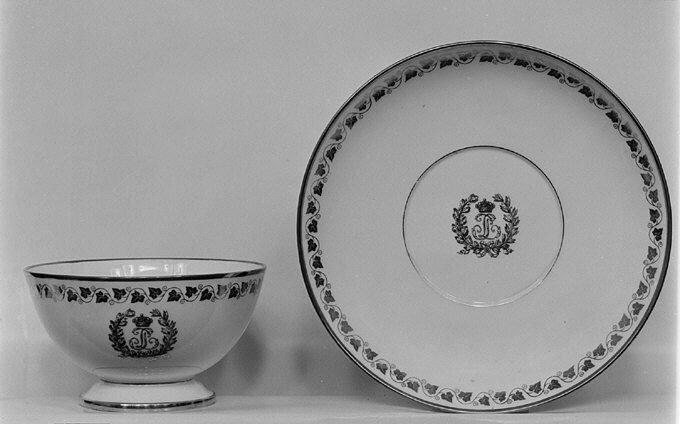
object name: cup and saucer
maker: sèvres manufactory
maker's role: manufactory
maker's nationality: french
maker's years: 1740-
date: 1801-1900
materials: soft paste porcelain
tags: flowers,insignia